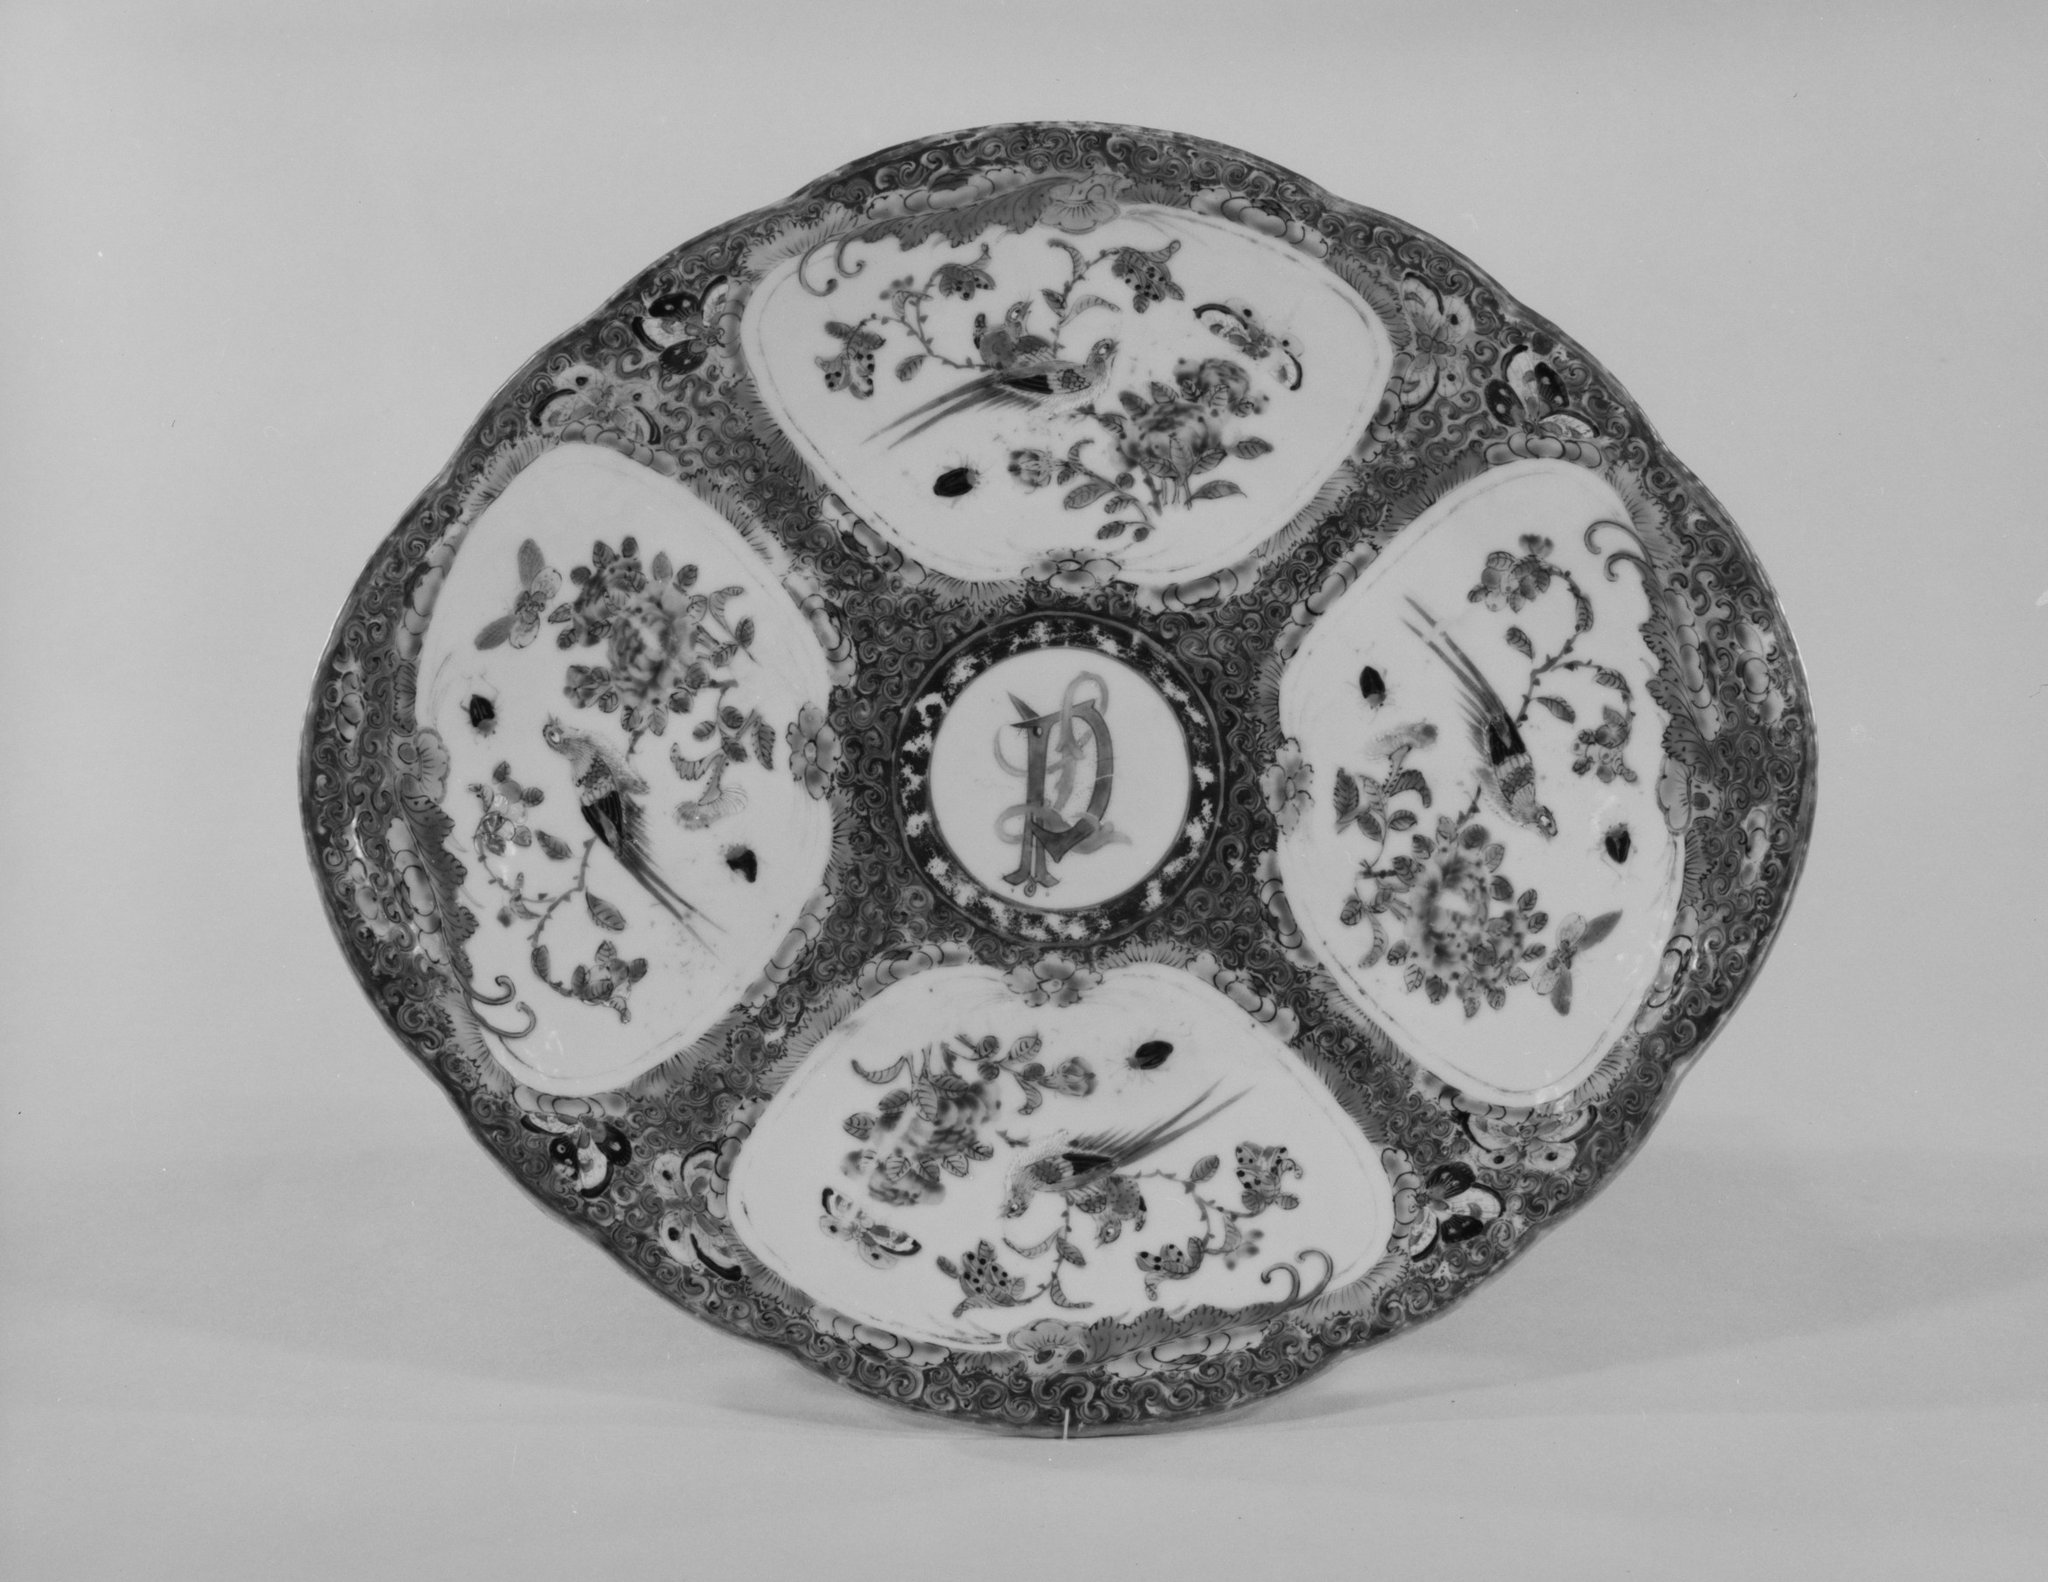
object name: dish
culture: chinese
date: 1860-1866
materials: porcelain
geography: china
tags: birds,butterflies,flowers